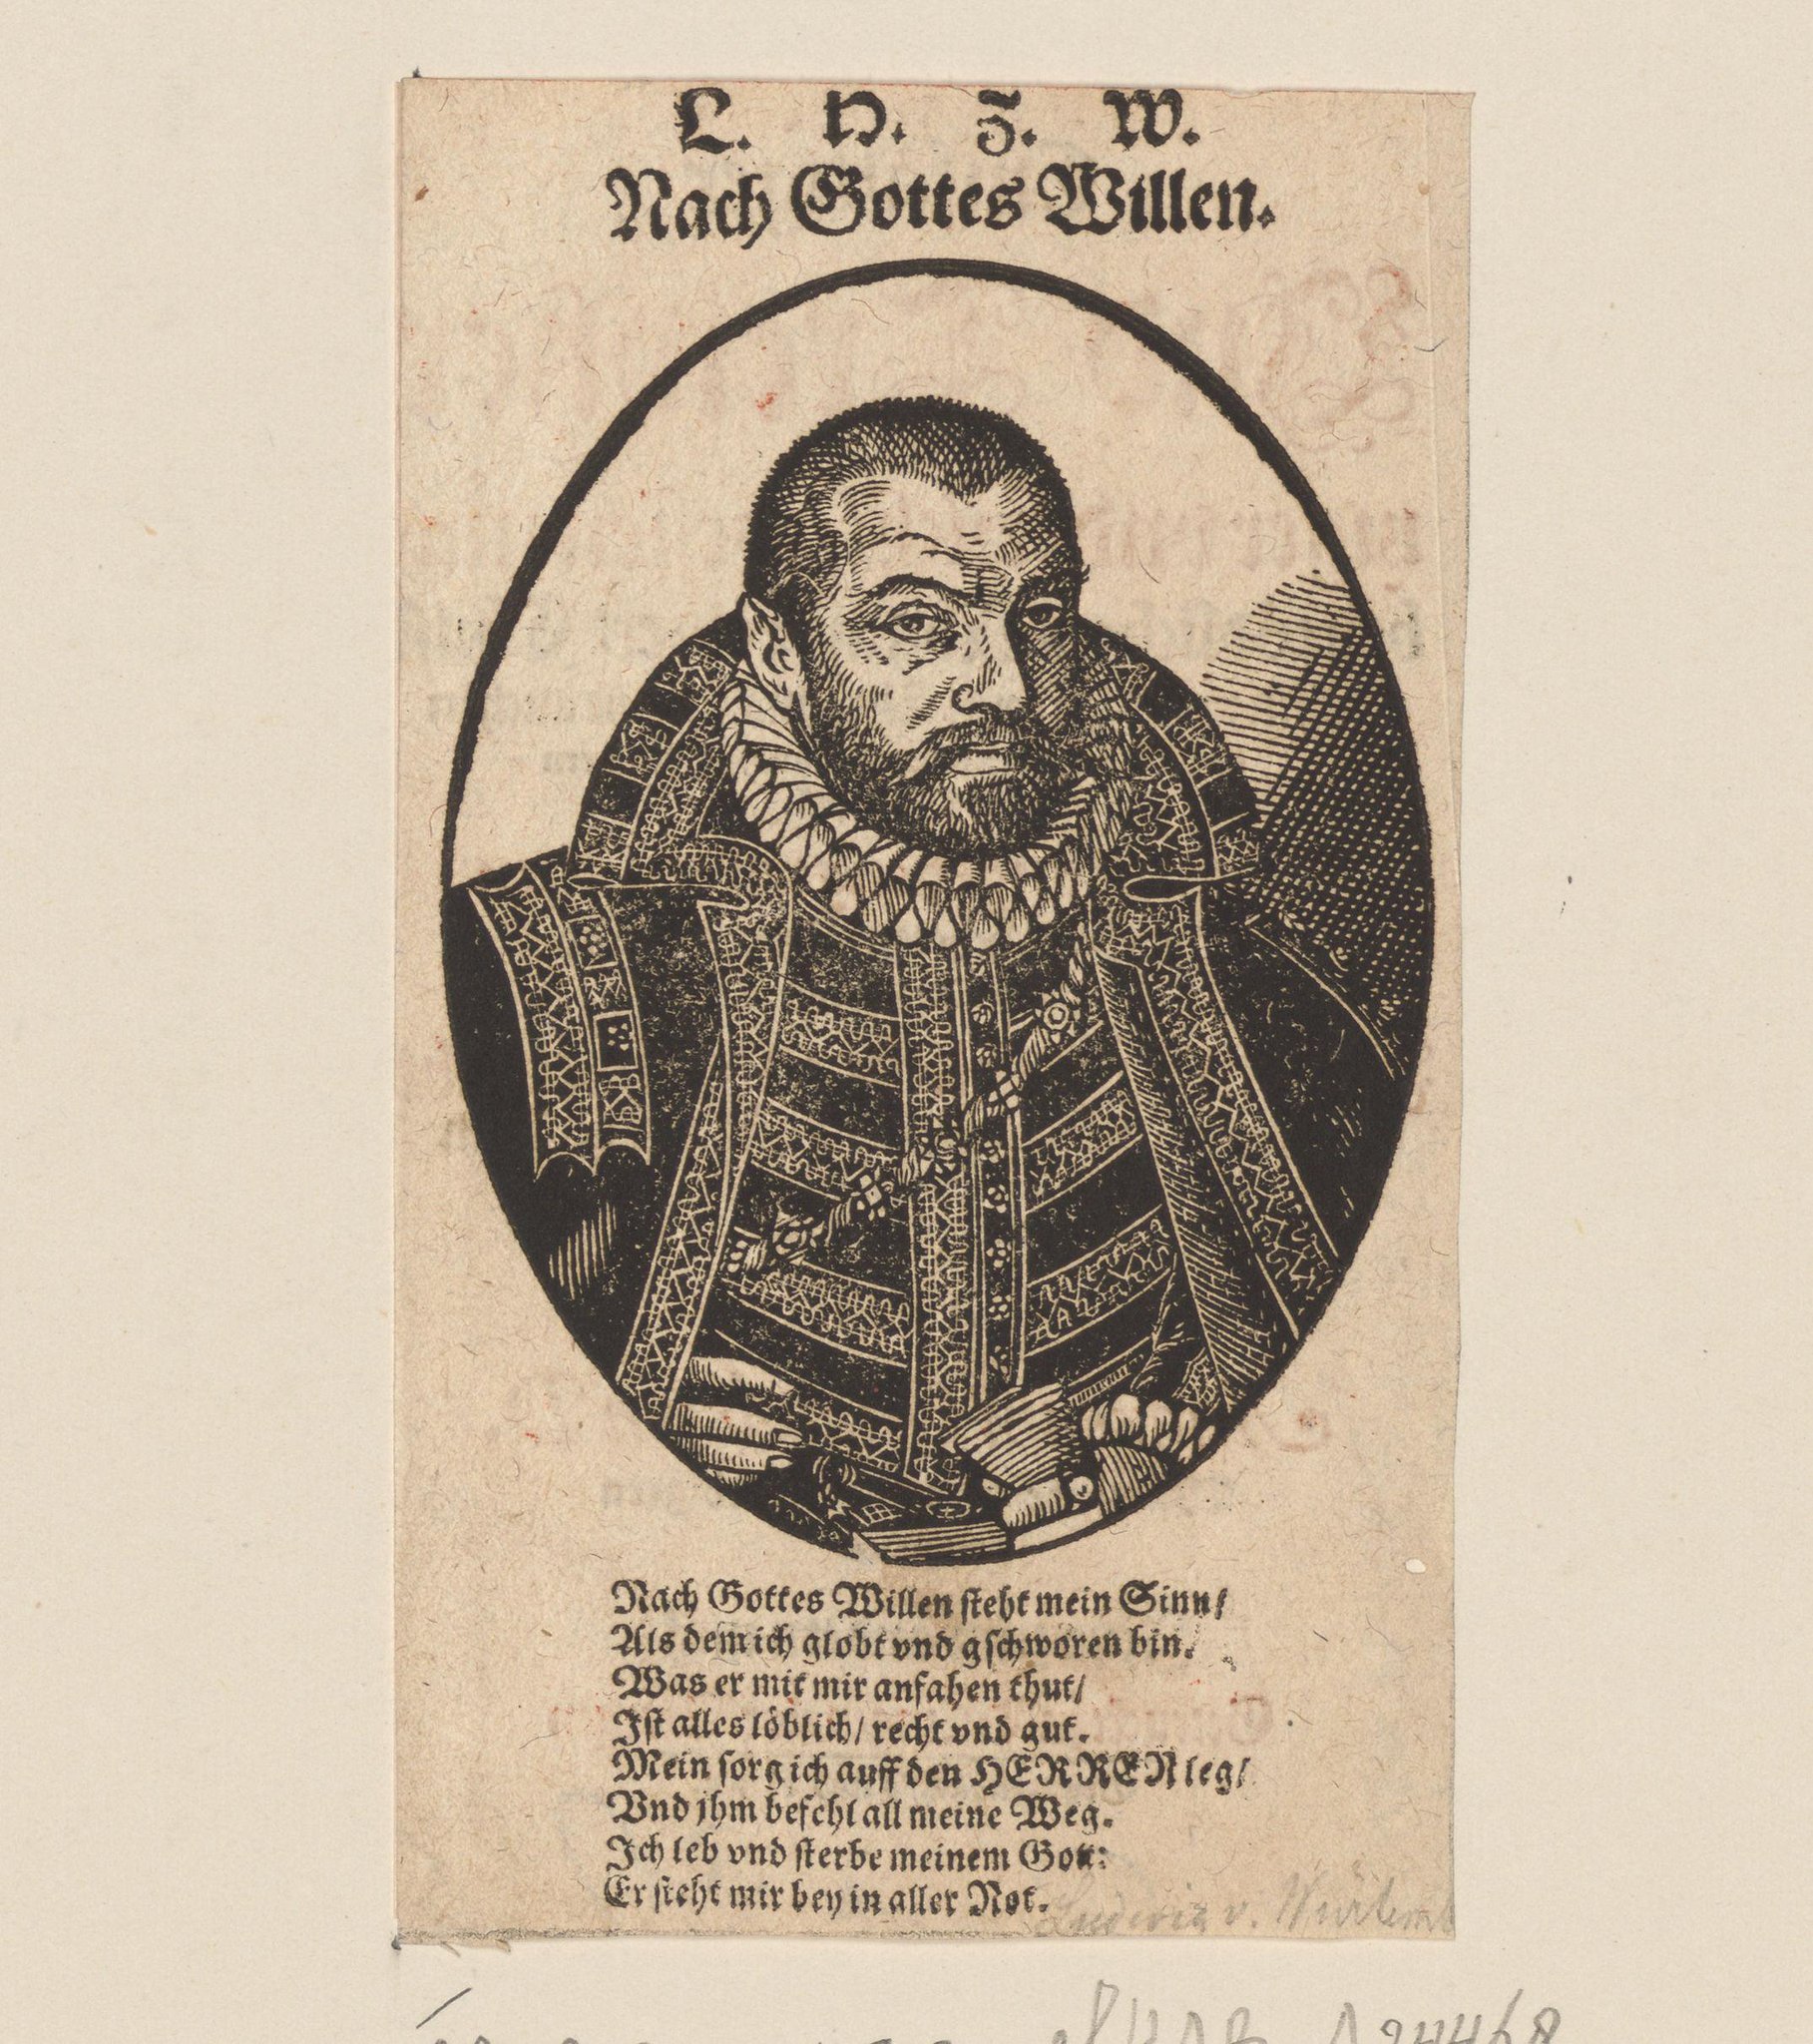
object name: book illustration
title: Portret van Lodewijk van Württemberg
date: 1594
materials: paper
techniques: letterpress printing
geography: germany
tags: historical persons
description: Verso is titelpagina van: Osiander, Andreas. Einfältiger und Trewhertziger underricht (...). Tübingen: Georg Gruppenbach, 1594.